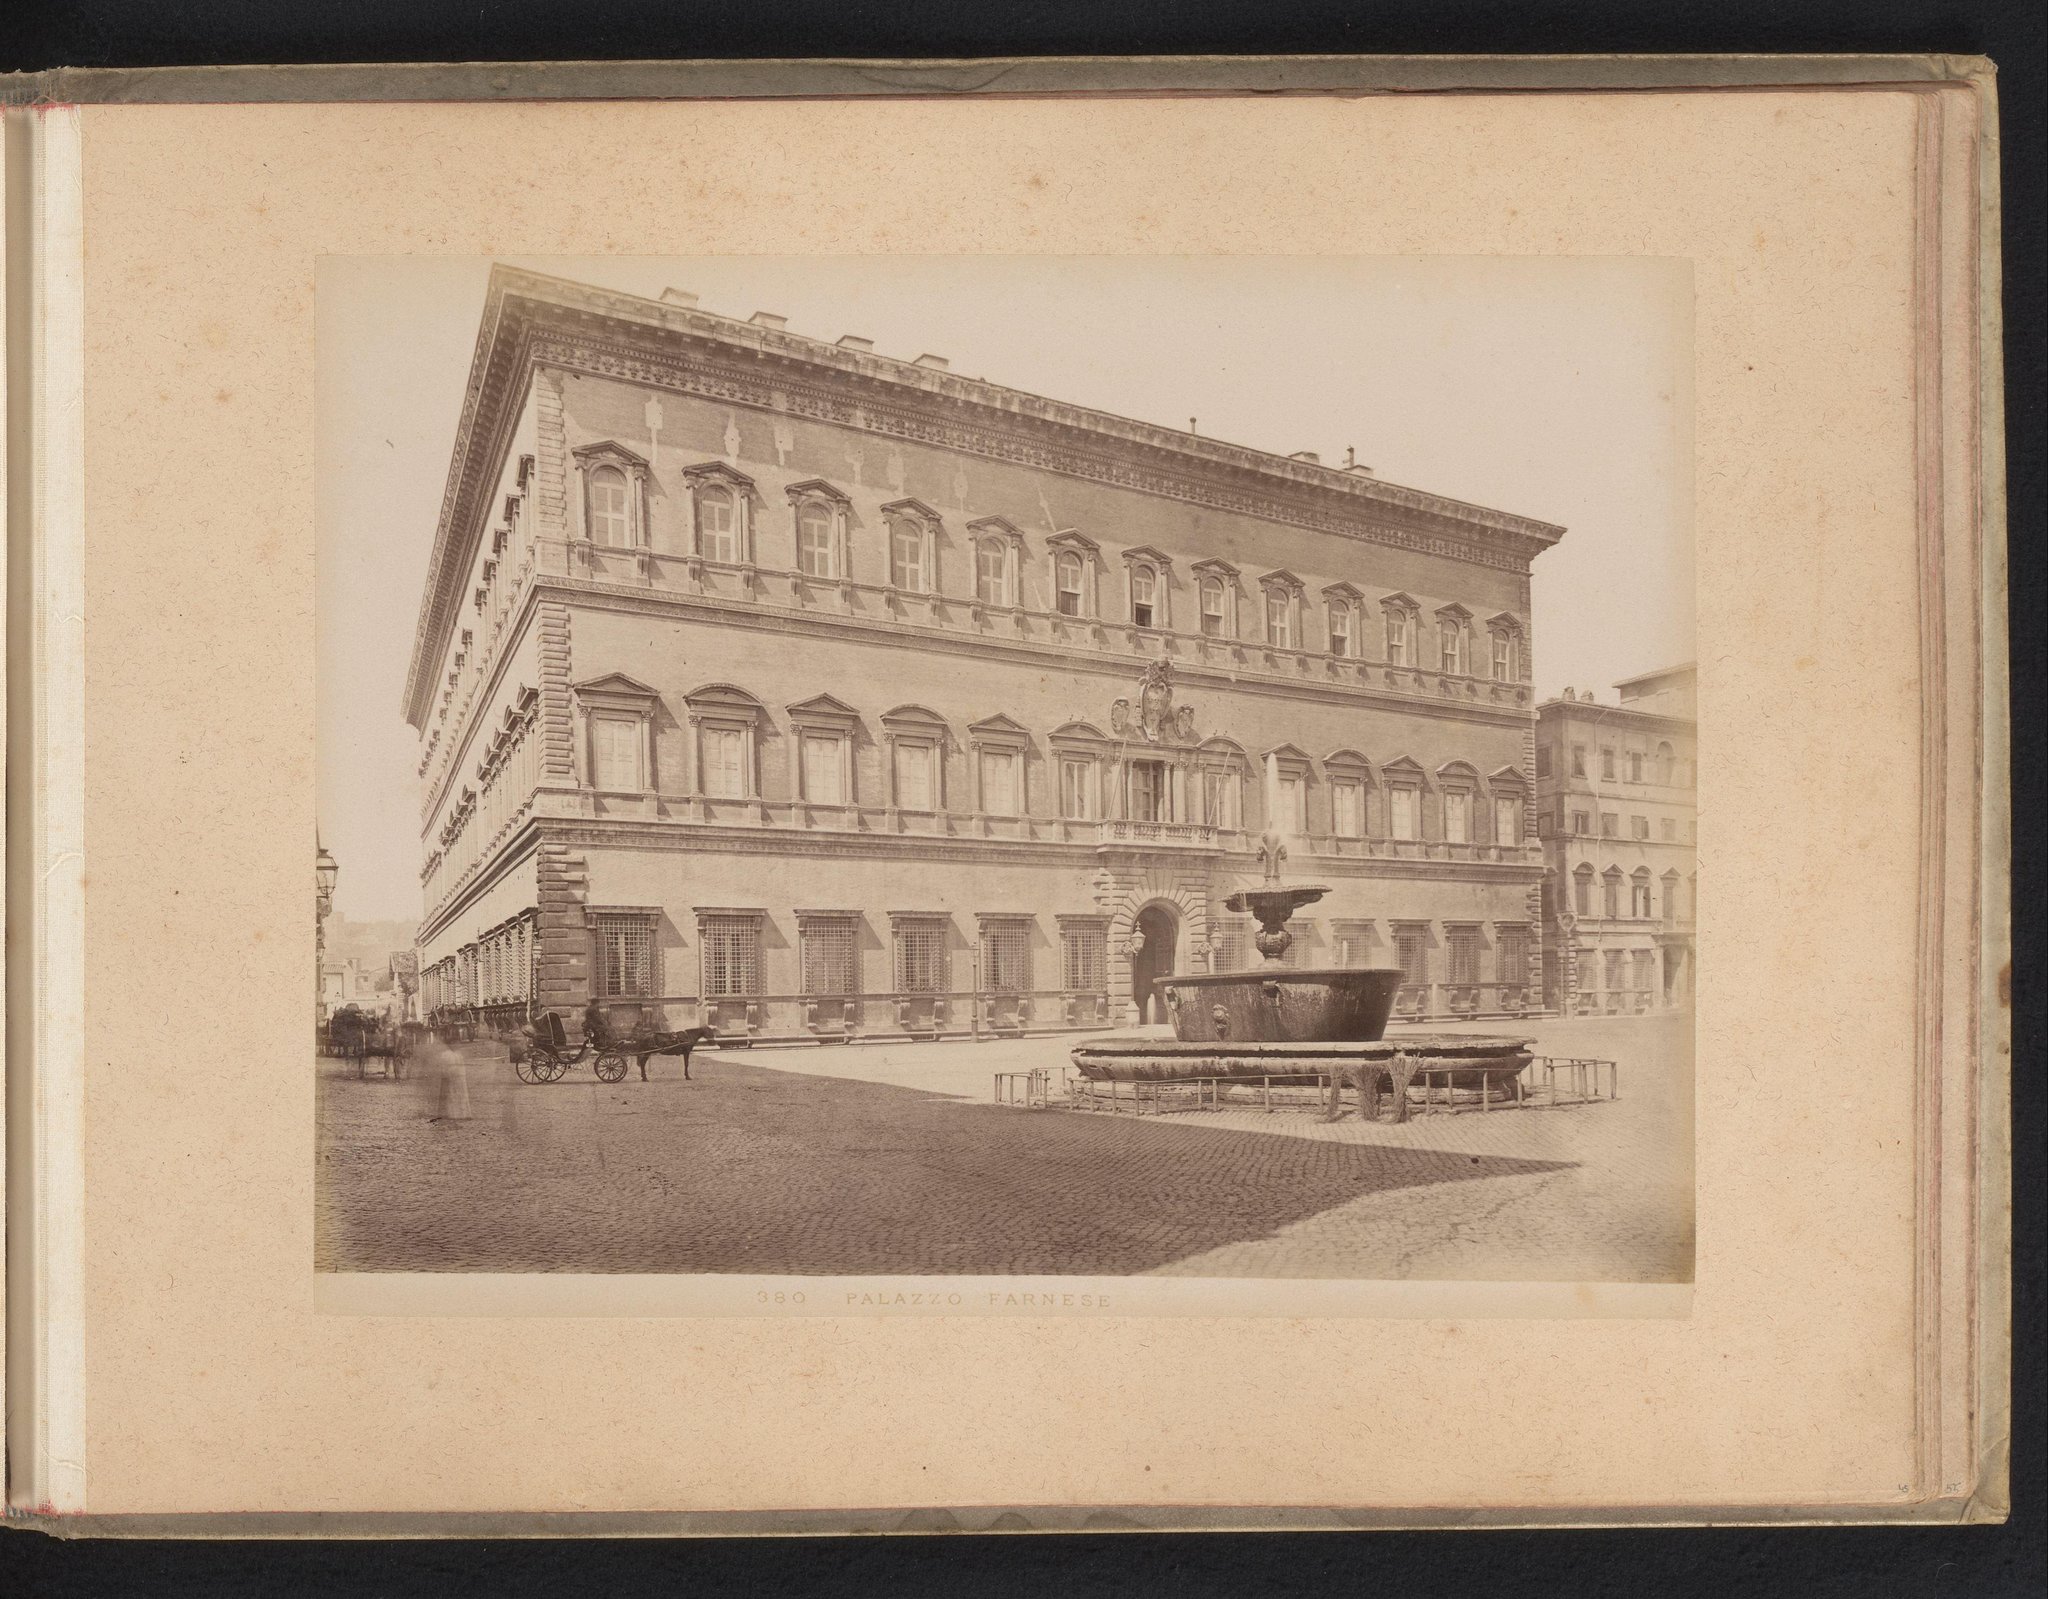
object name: album leaf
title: Gezicht op het Palazzo Farnese in Rome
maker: Anonymous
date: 1870-1895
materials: cardboard, photographic support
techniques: albumen print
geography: rome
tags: palace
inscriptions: inscription: ‘60 IL CAMPIDOGLIO’